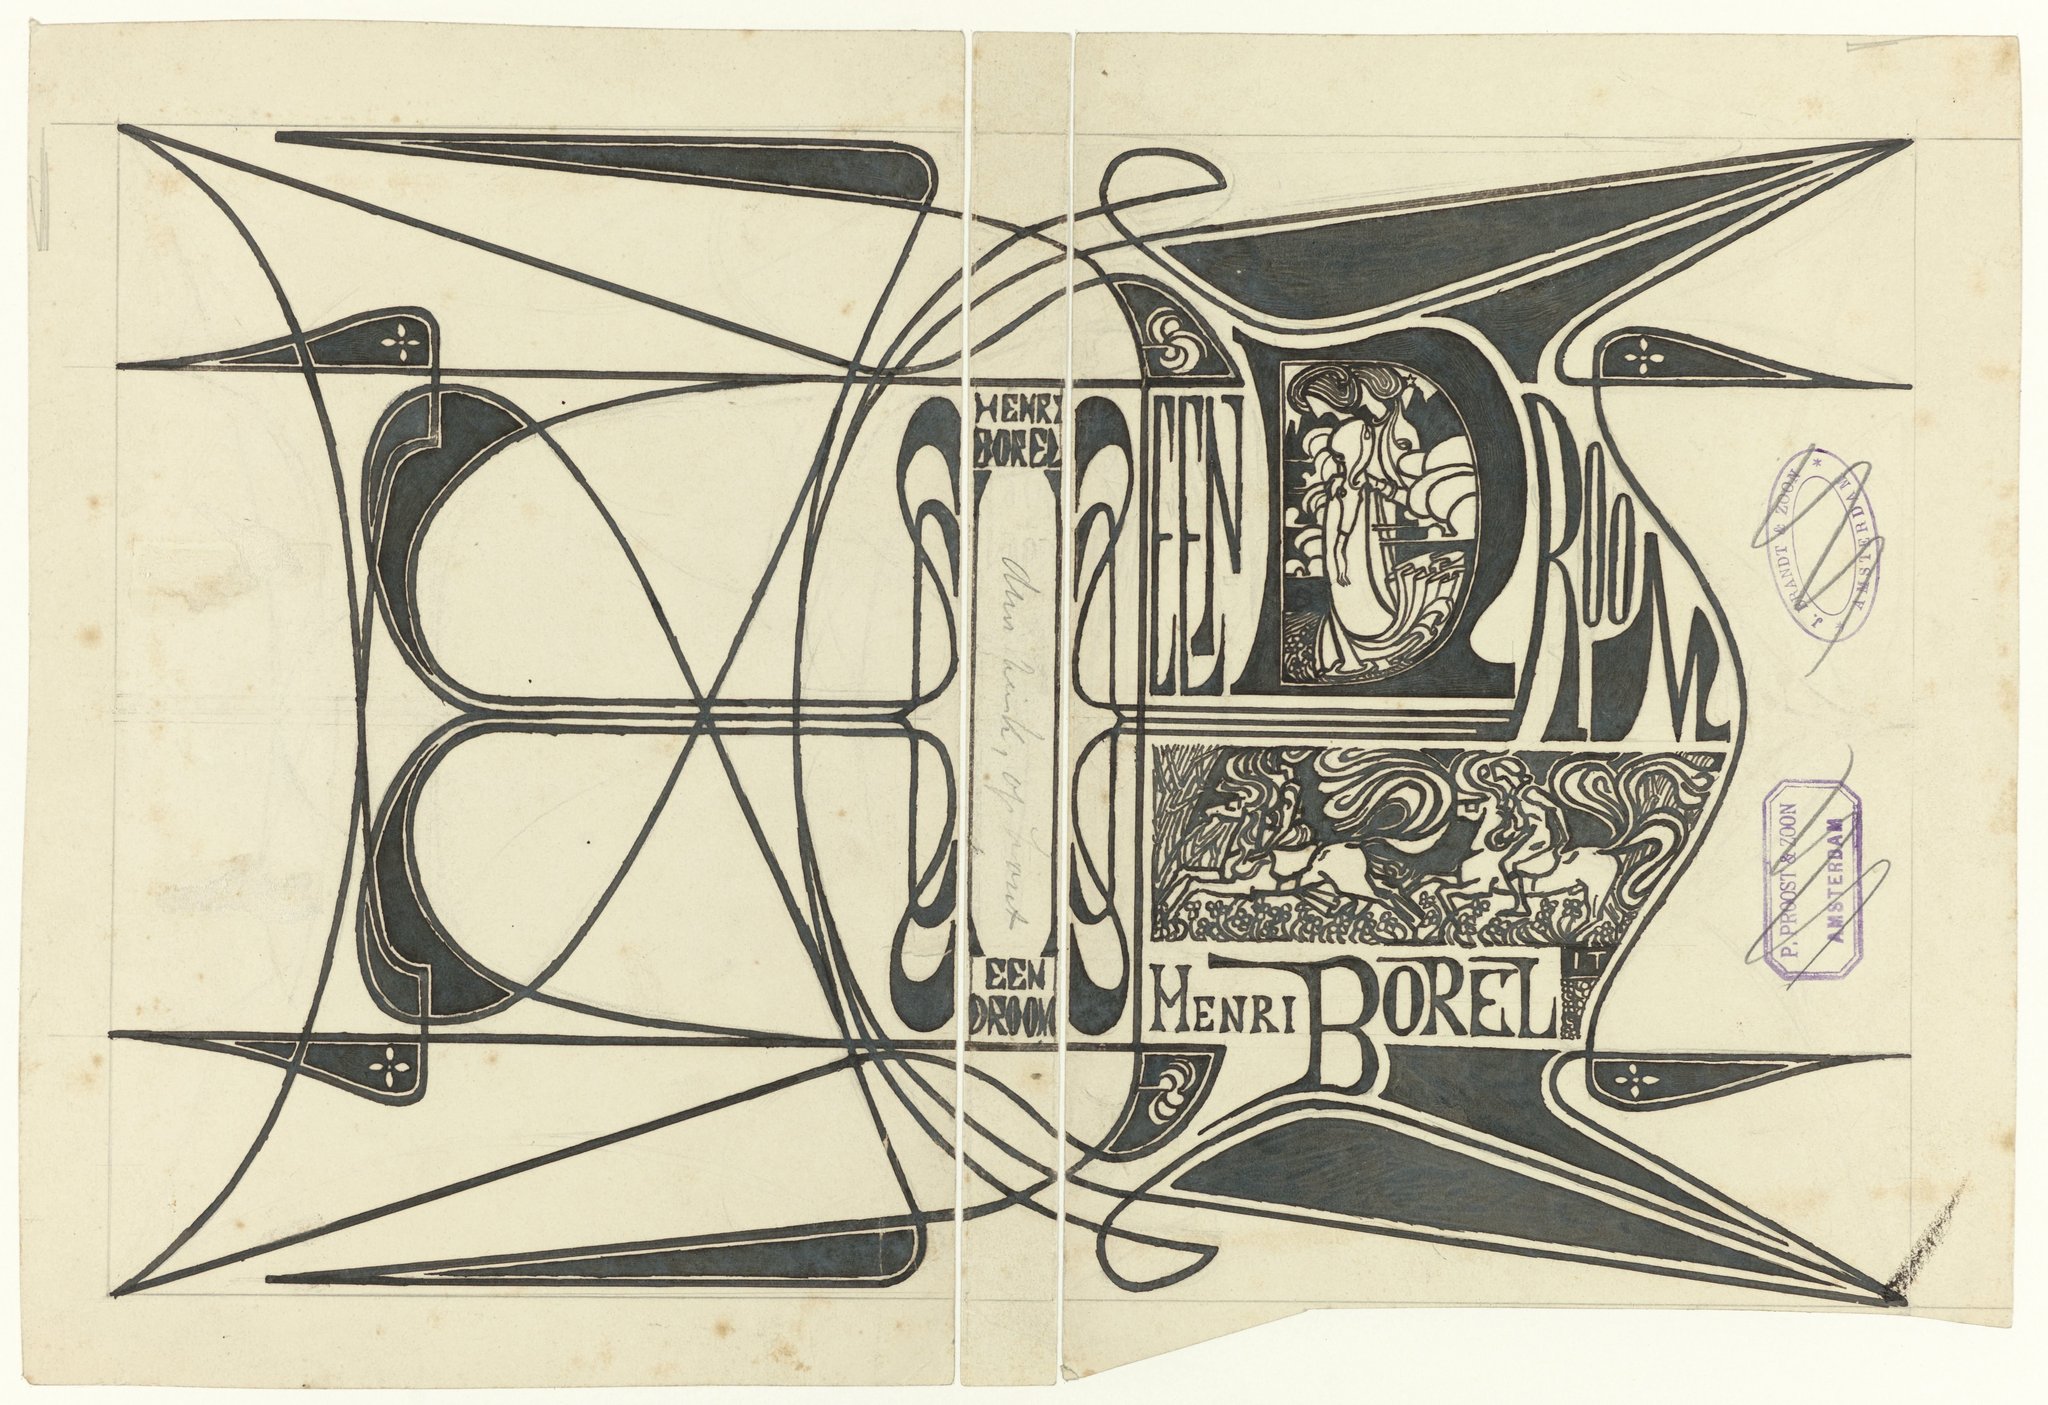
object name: study for binding design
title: Bandontwerp voor: Henri Borel, Een droom, 1899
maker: jan toorop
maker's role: draughtsman, painter, print maker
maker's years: 1858-1928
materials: ink, paper, pencil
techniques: brush, pen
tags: riding a horse, ass, or mule; rider, horseman, ornament ~ combination of straight and curved lines, landscapes (+ landscape with figures, staffage)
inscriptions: collector's mark: Lugt 2228a, mark: ‘J. BRANDT & ZOON/ AMSTERDAM’, retailer's mark: ‘P. PROOST & ZOON/ AMSTERDAM’, annotation: ‘dun zink, op hout’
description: Het ontwerp bestaat uit drie fysiek losse onderdelen, die bijeen zijn opgezet. Het boek waarvoor het ontwerp werd gemaakt werd in 1899 uitgegeven bij uitgeverij P.N. Van Kampen te Amsterdam, niet bij Uitgeverij L.J. Veen.